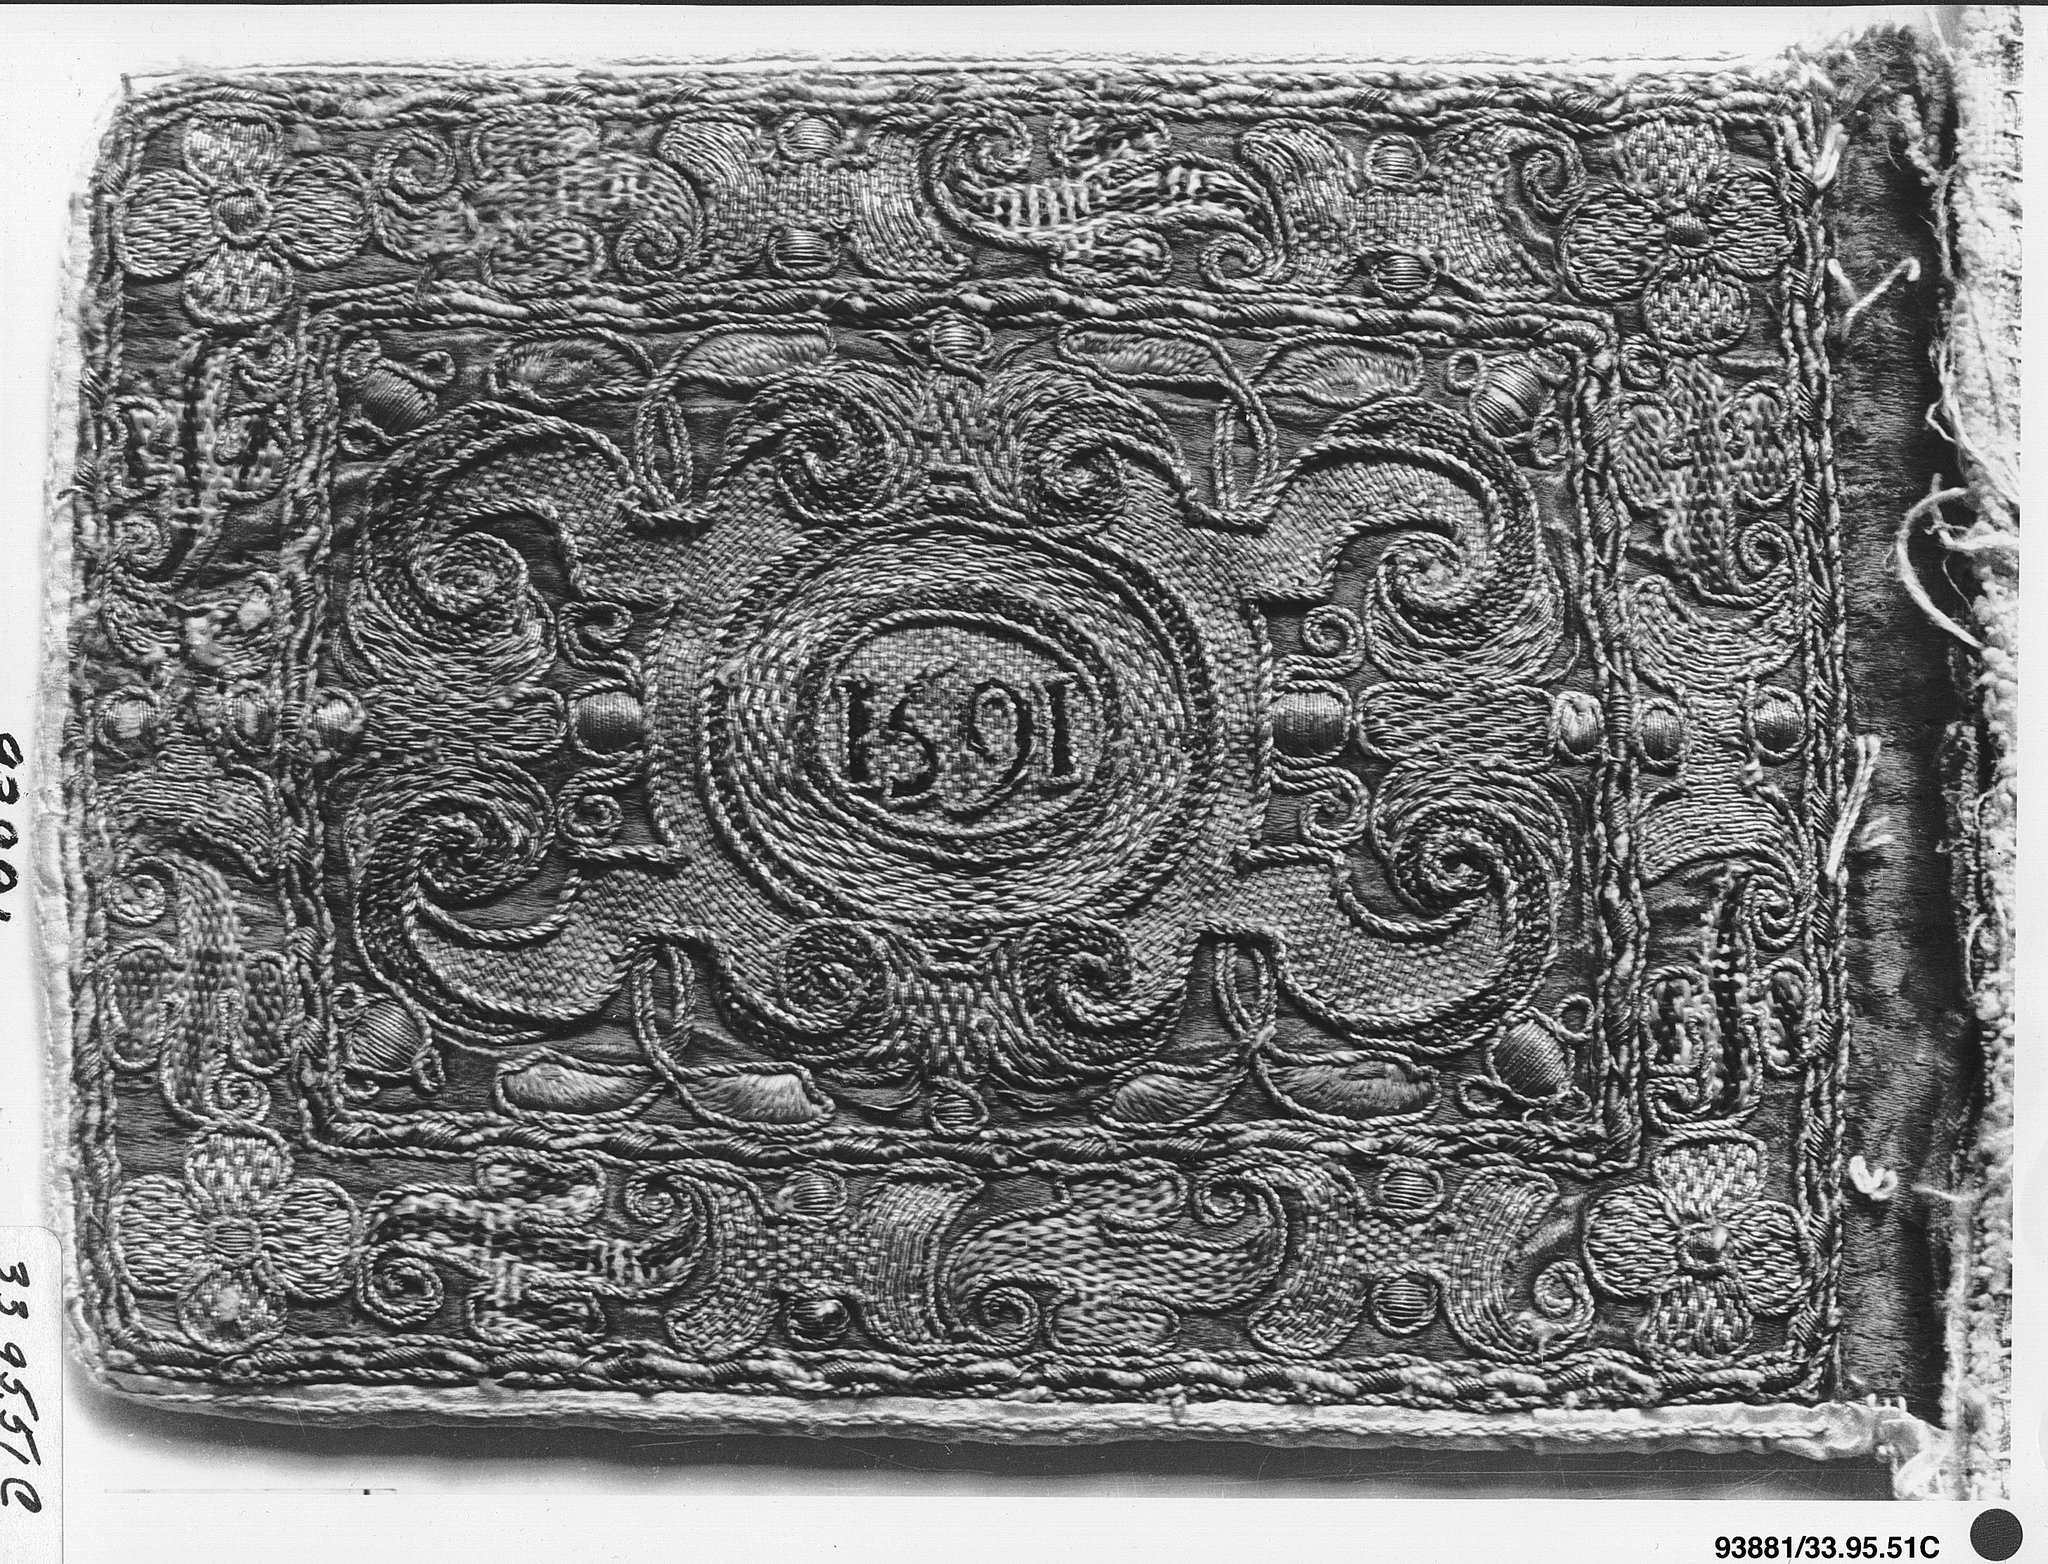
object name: morse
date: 1591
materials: metal thread, silk